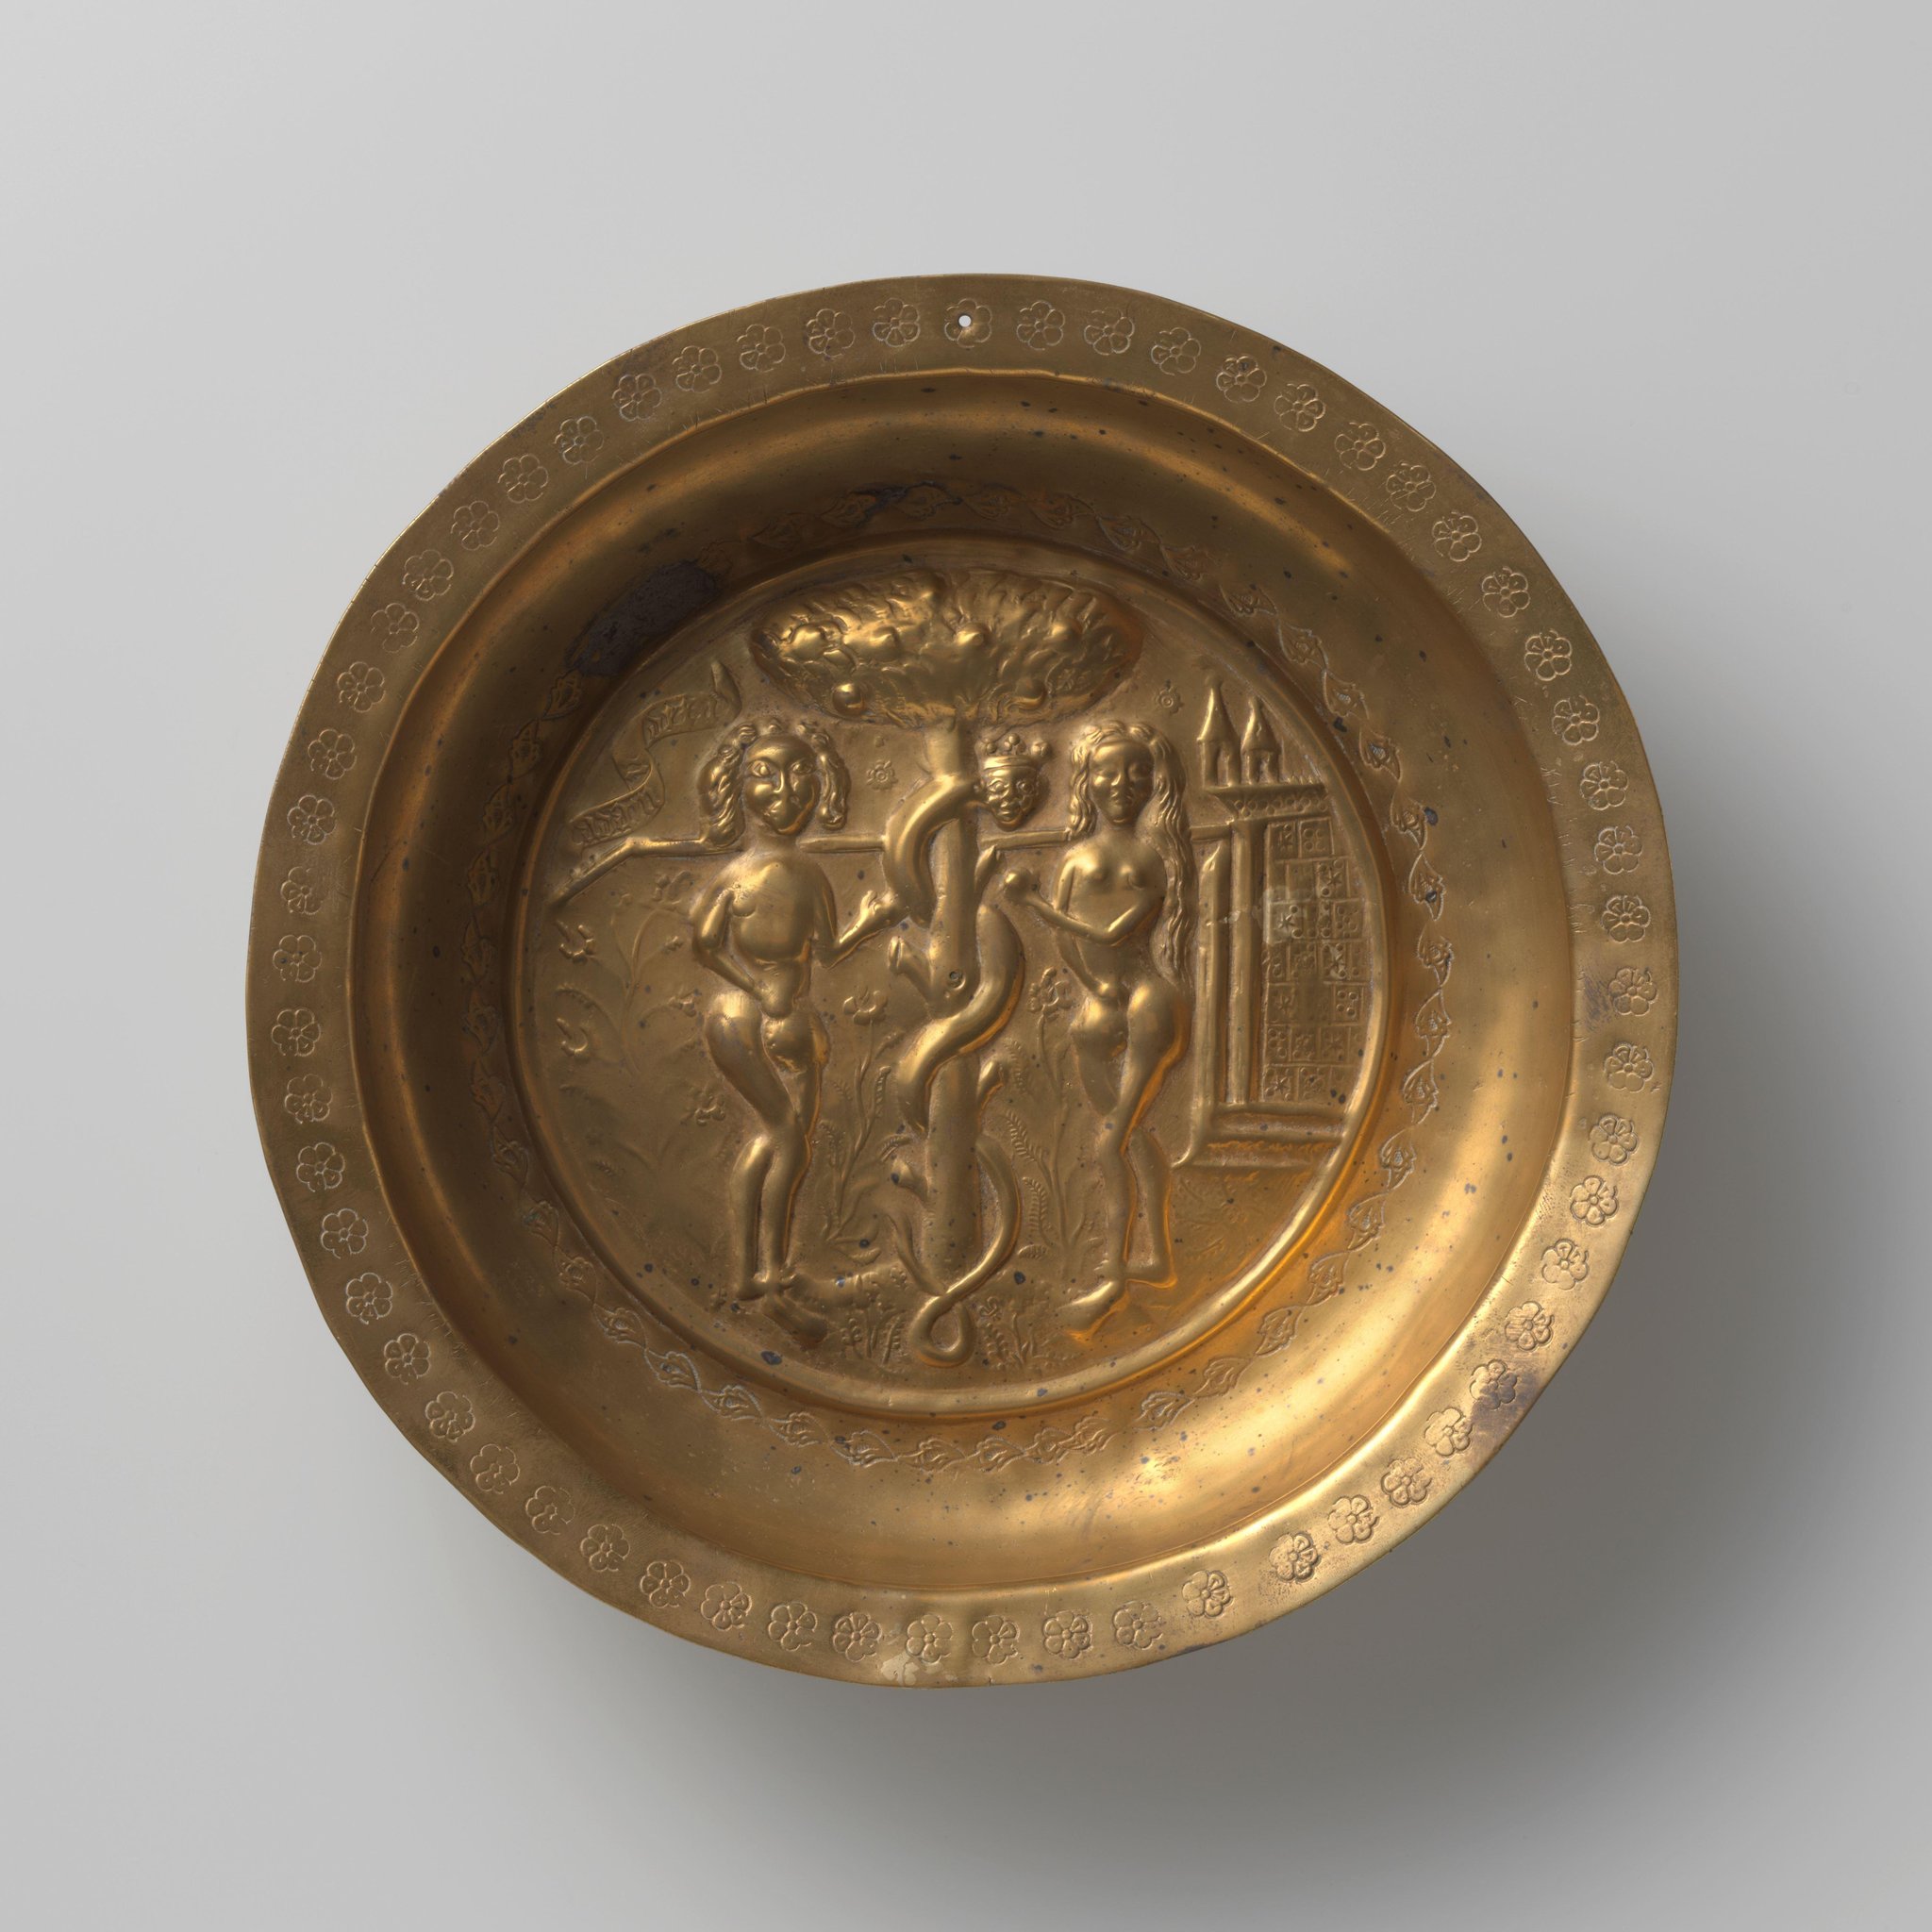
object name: bekken schaal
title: Bekken met Adam en Eva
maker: Anonymous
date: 1500-1600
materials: brass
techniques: casting, engraving, punching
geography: nuremberg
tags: eve offers the fruit to adam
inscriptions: inscription: ‘Adam und Eva’, inscription: ‘THP’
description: In het plat van de schotel, die in het midden het centerpunt heeft, is met behulp van een stempelvorm geponst een voorstelling van Adam en Eva in het Paradijs (Genesis 3,1-8). De tekst van de spreuk luidt: Adam und Eva. Om dit tafereel is een geponst ornament aangebracht met als motief een gestileerd blad. Op de rand van het bekken zijn rozetten geponst. De hangring aan de achterzijde en het gat in de rand zijn later aangebracht.